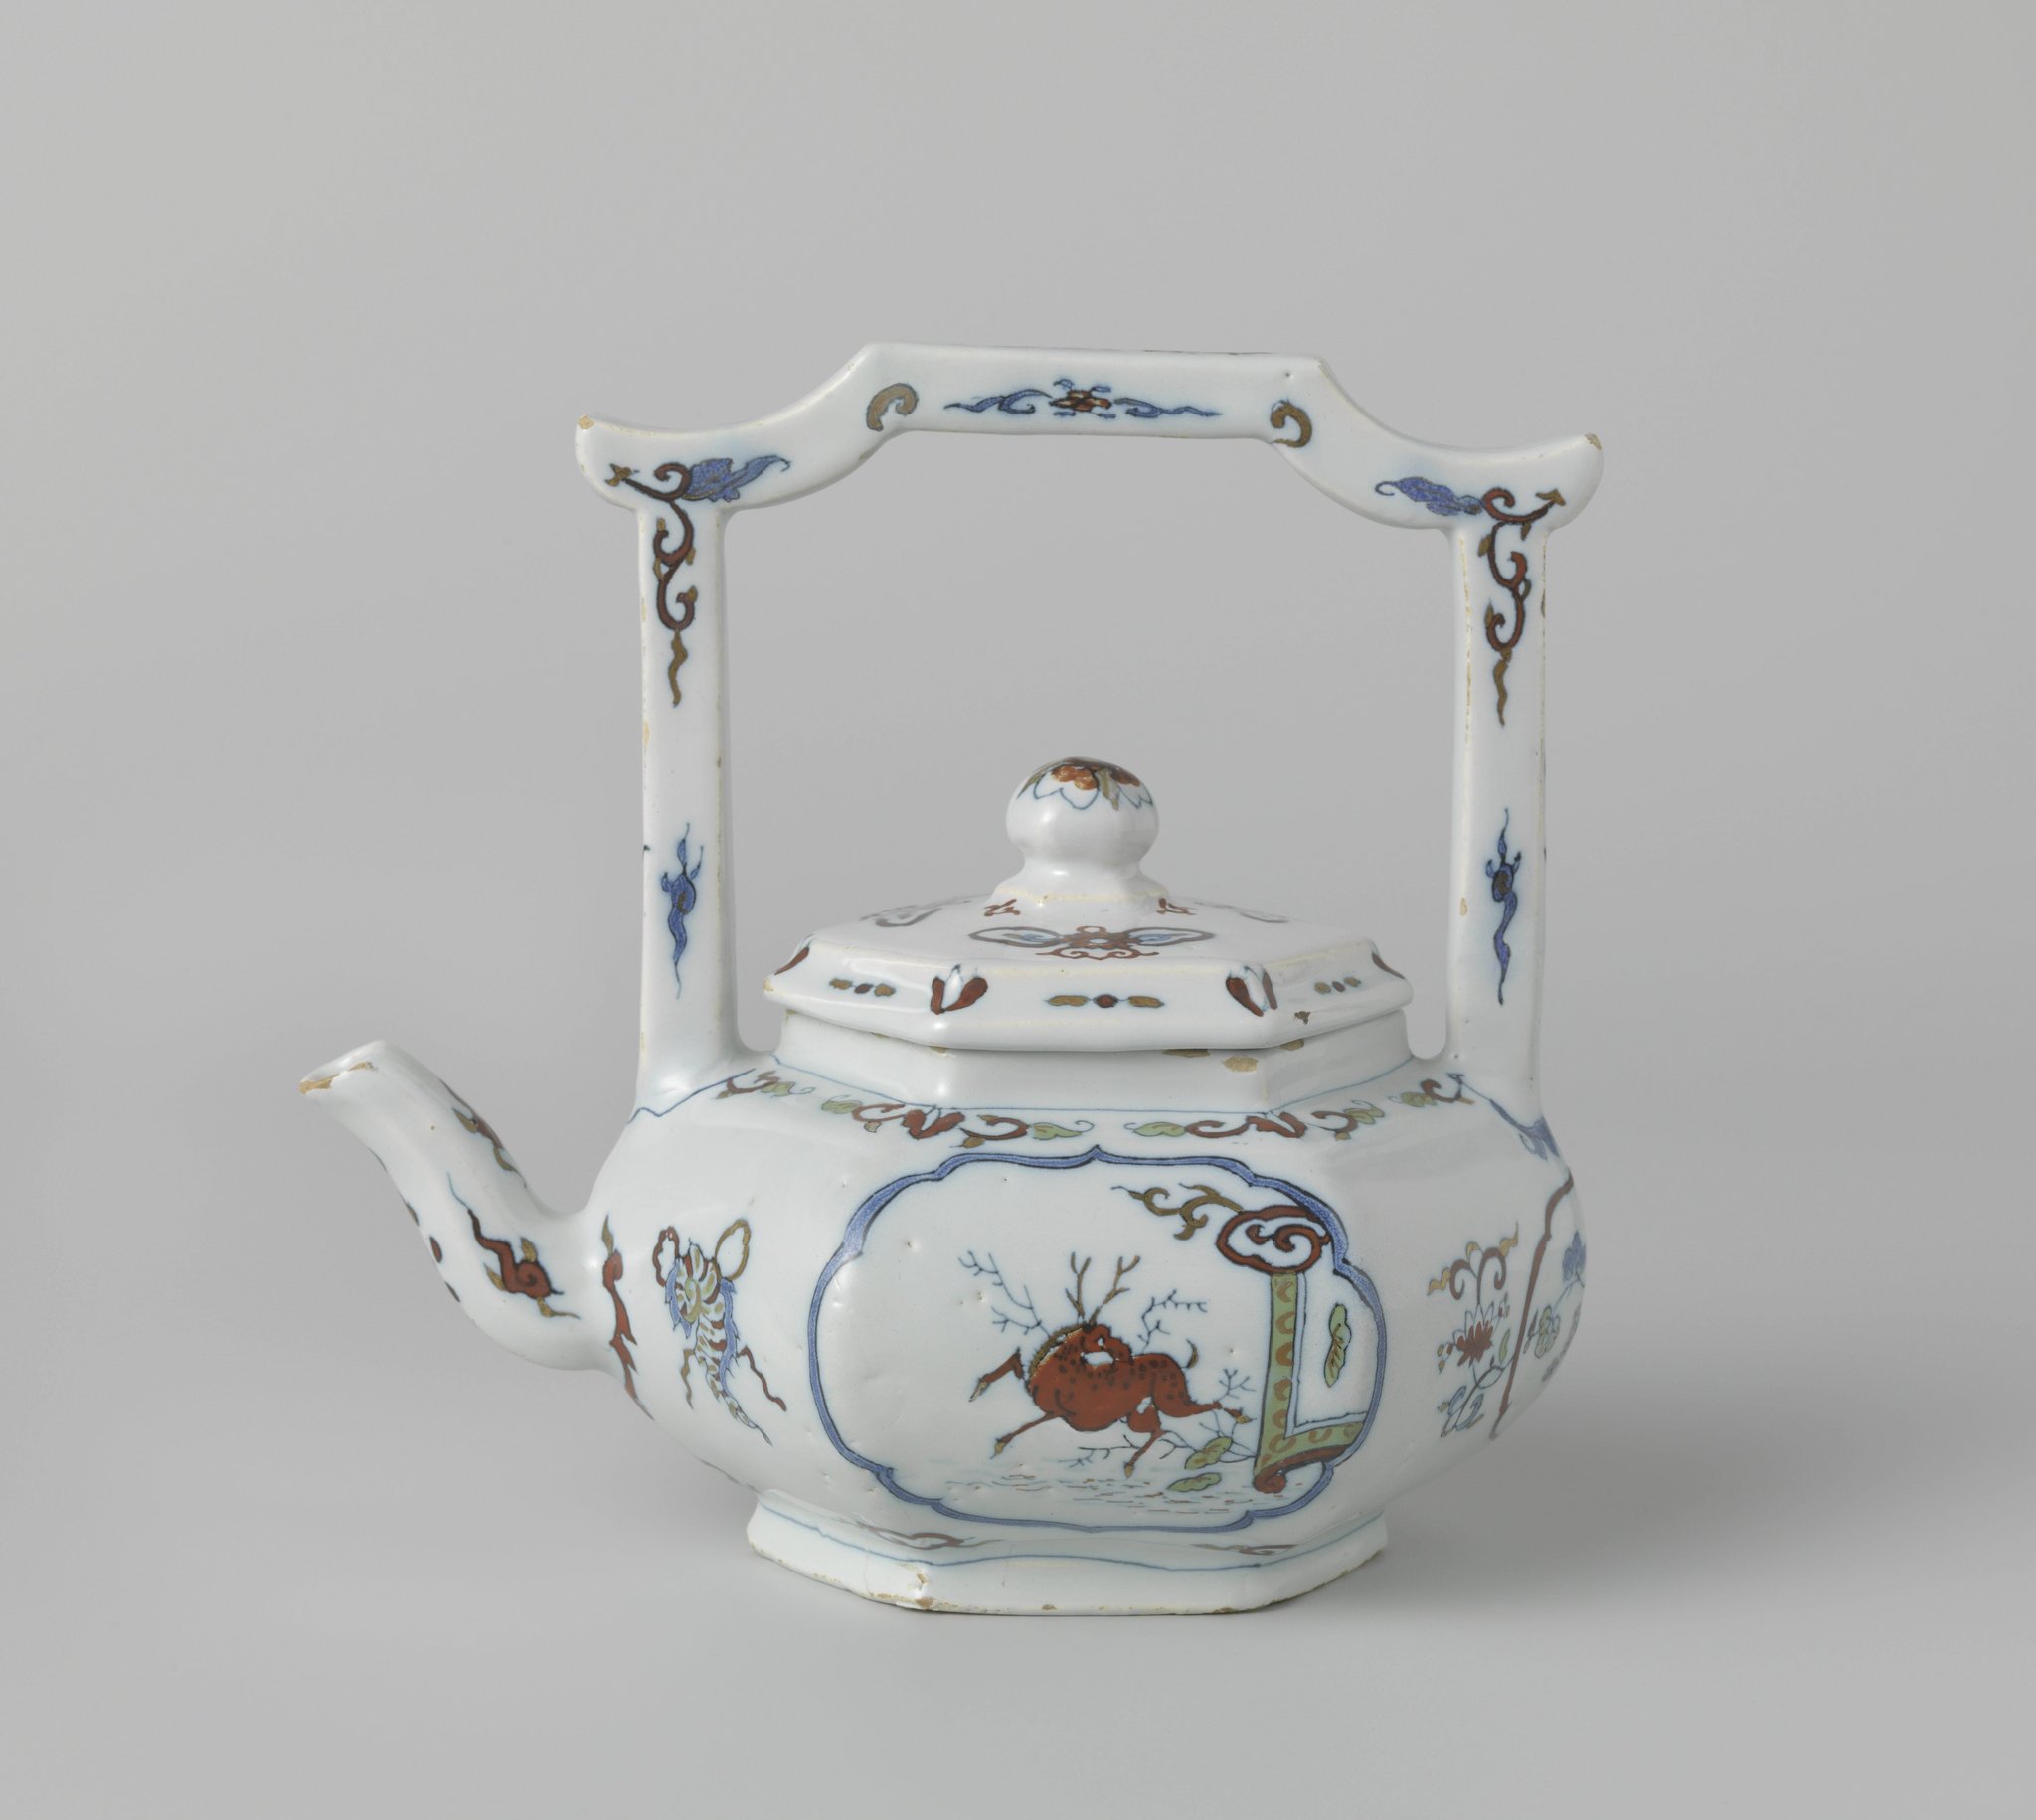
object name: teapot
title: Two Teapots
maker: rochus jacobsz. hoppesteijn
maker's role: plateelbakker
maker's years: -1692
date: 1685-1690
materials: earthenware, glaze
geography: delft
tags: hoofed animals: deer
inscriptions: mark: ‘RIHS(ineen)’, mark: ‘figuratief teken met het hoofd zwarte man’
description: The form of these two teapots is almost identical and is derived from Chinese stoneware. They were produced shortly after each other in the same Delft pottery. The blue and white teapot was made when Jacob Hoppesteyn (and from 1671 his widow Jannetje) was in charge of the factory, the coloured one under the directorship of their son Rochus. Because the shape of the teapots is so similar, their very different decorations stand out all the more.